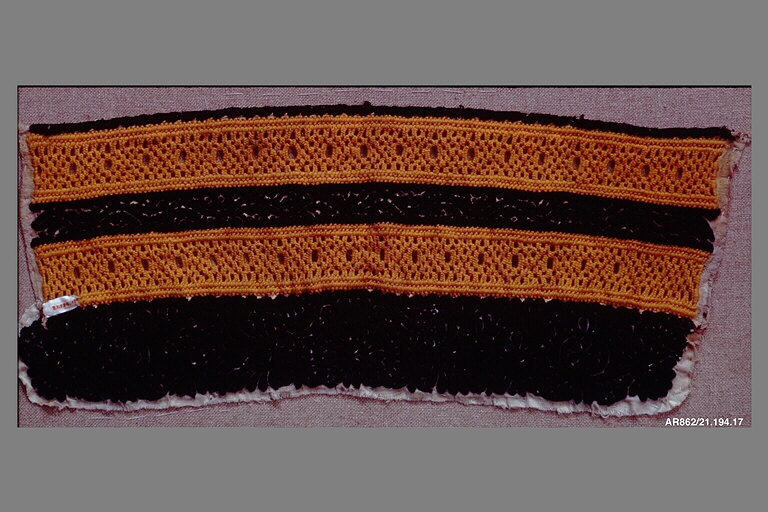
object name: cuff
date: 1801-1900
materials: linen, wool